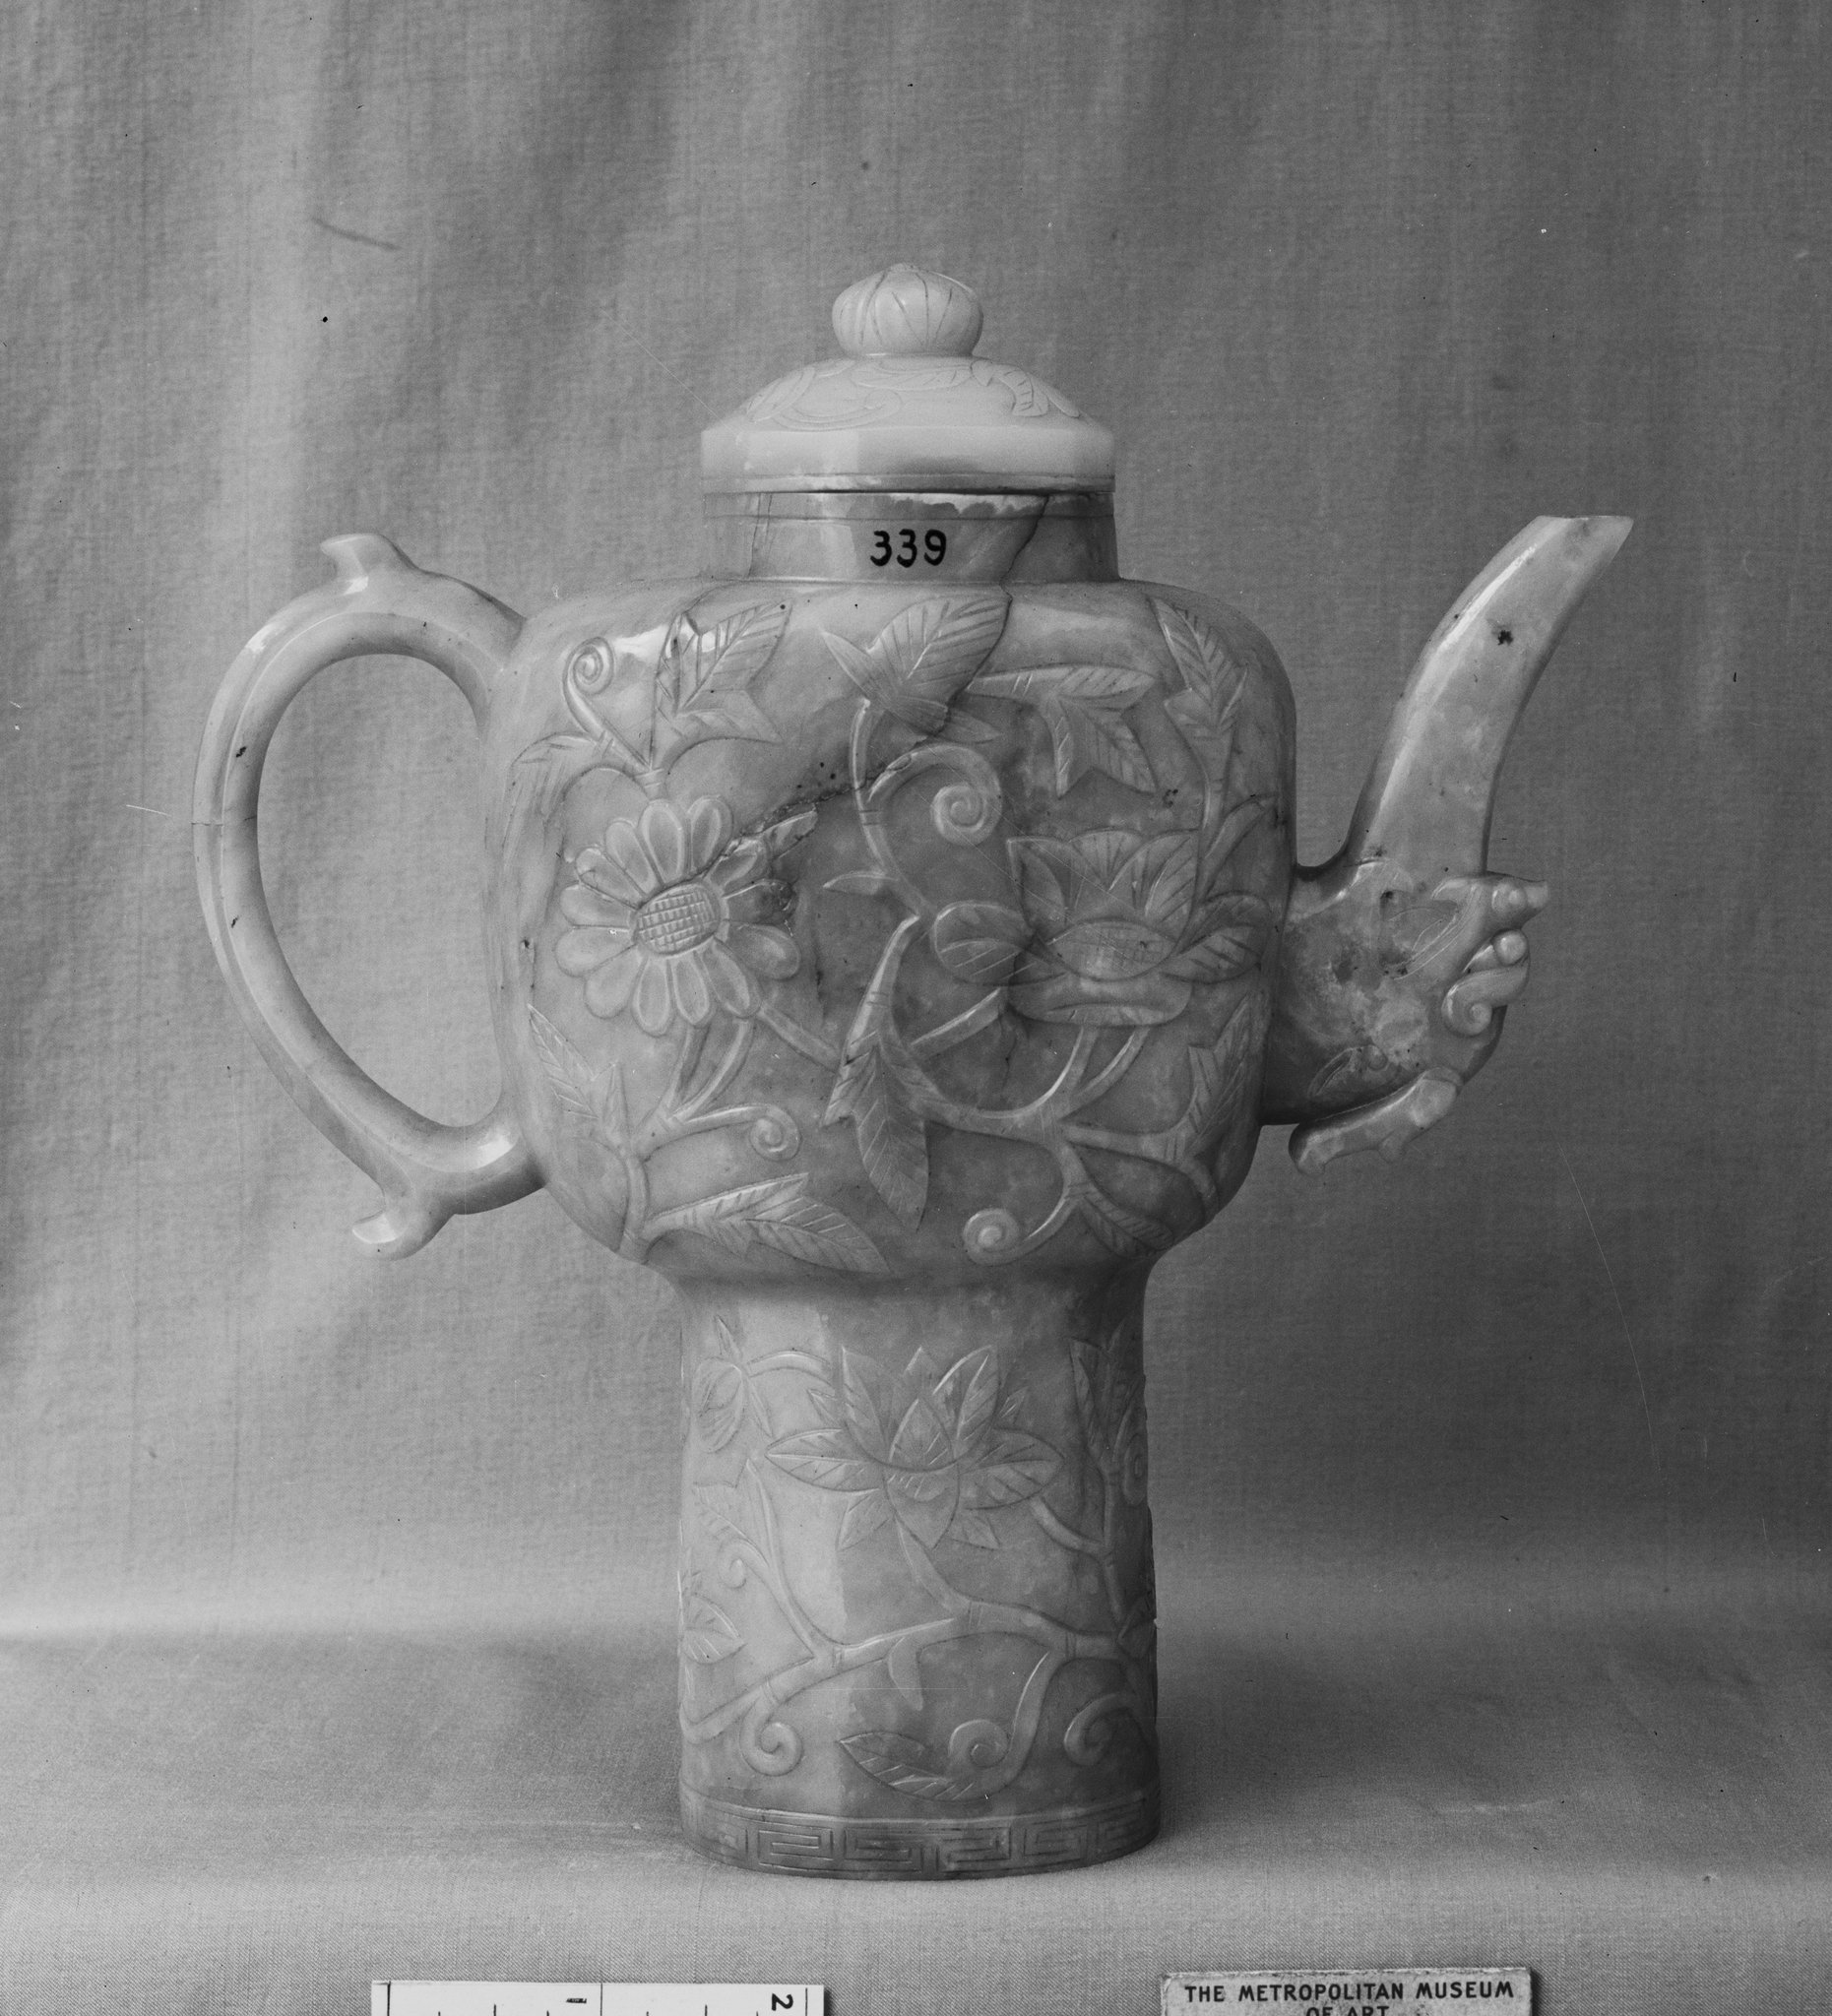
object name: wine pot with cover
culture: chinese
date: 1368-1644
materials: jade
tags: flowers